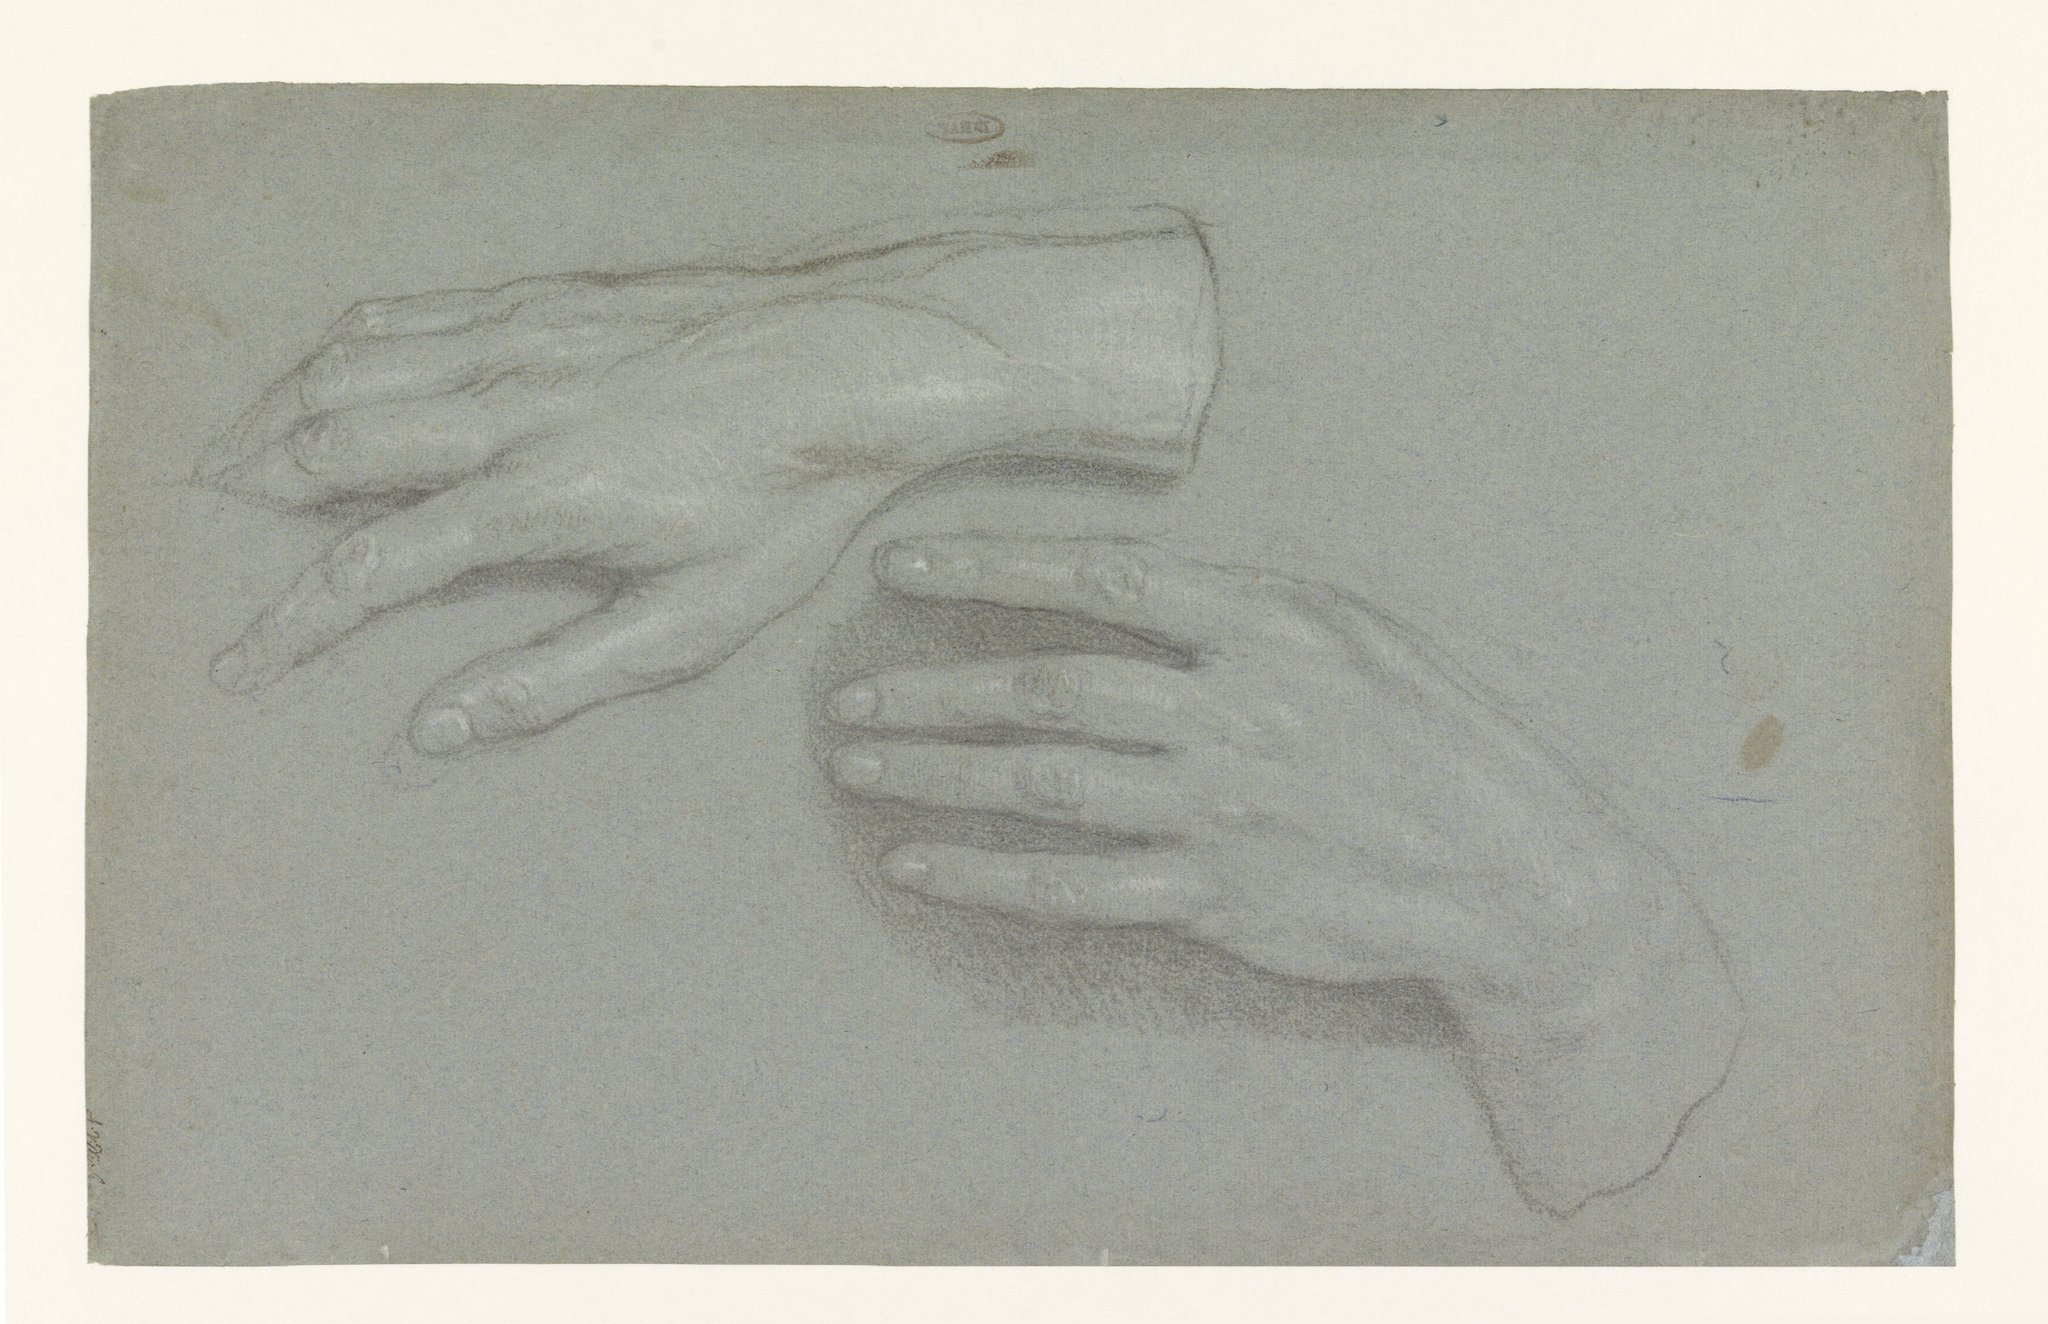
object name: drawing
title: Twee studies van handen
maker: anthony van dyck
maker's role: draughtsman, painter, print maker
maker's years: 1599-1641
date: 1610-1641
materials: chalk, paper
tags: hand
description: Afkomstig uit een tekeningenalbum met onder andere figuur- en handstudies van of naar Caspar en Constantijn Netscher (BI-1894-3720). Tekening bevond zich oorspronkelijk op f. 31.